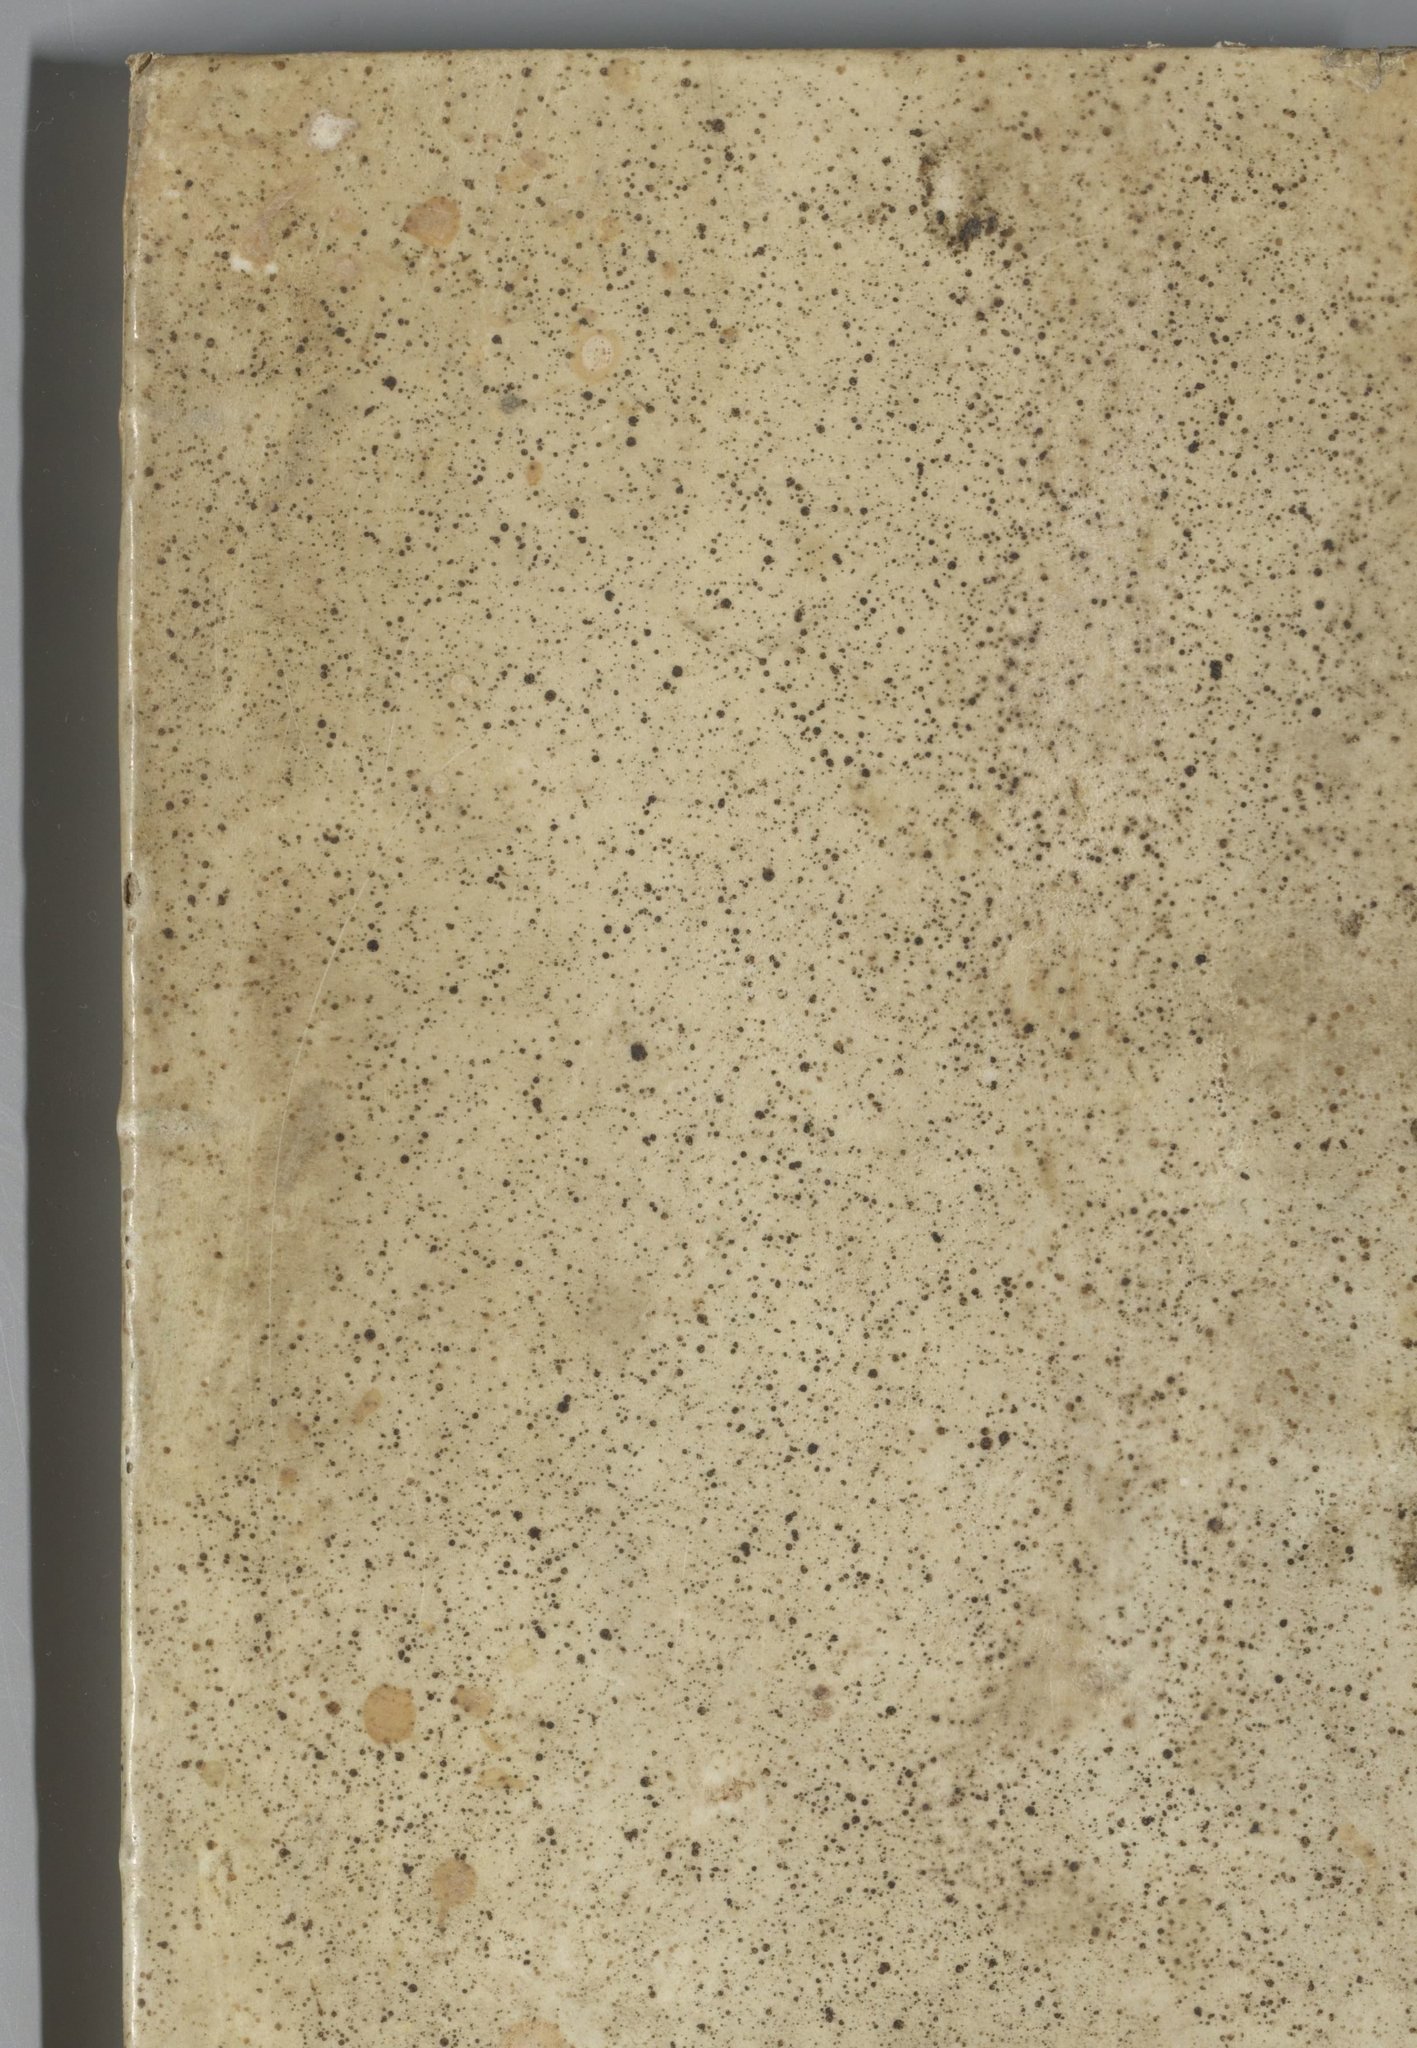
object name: prentrecueil, prentenalbum, prentalbum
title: Album met voorstellingen van Chinese figuren en landschappen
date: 1727-1775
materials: paper, parchment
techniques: bookbinding, etching, hand coloring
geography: amsterdam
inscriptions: bookplate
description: Album met 84 etsen op 84 albumbladen. Het album bevat negen prentseries met chinoiserieën. Chinese figuren, landschappen, dieren, bloemen en objecten, die onder andere bedoeld zijn als voorbeelden voor het versieren van keramiek en aardewerk. Gespikkelde perkamenten band met voorin en achterin een schutblad.